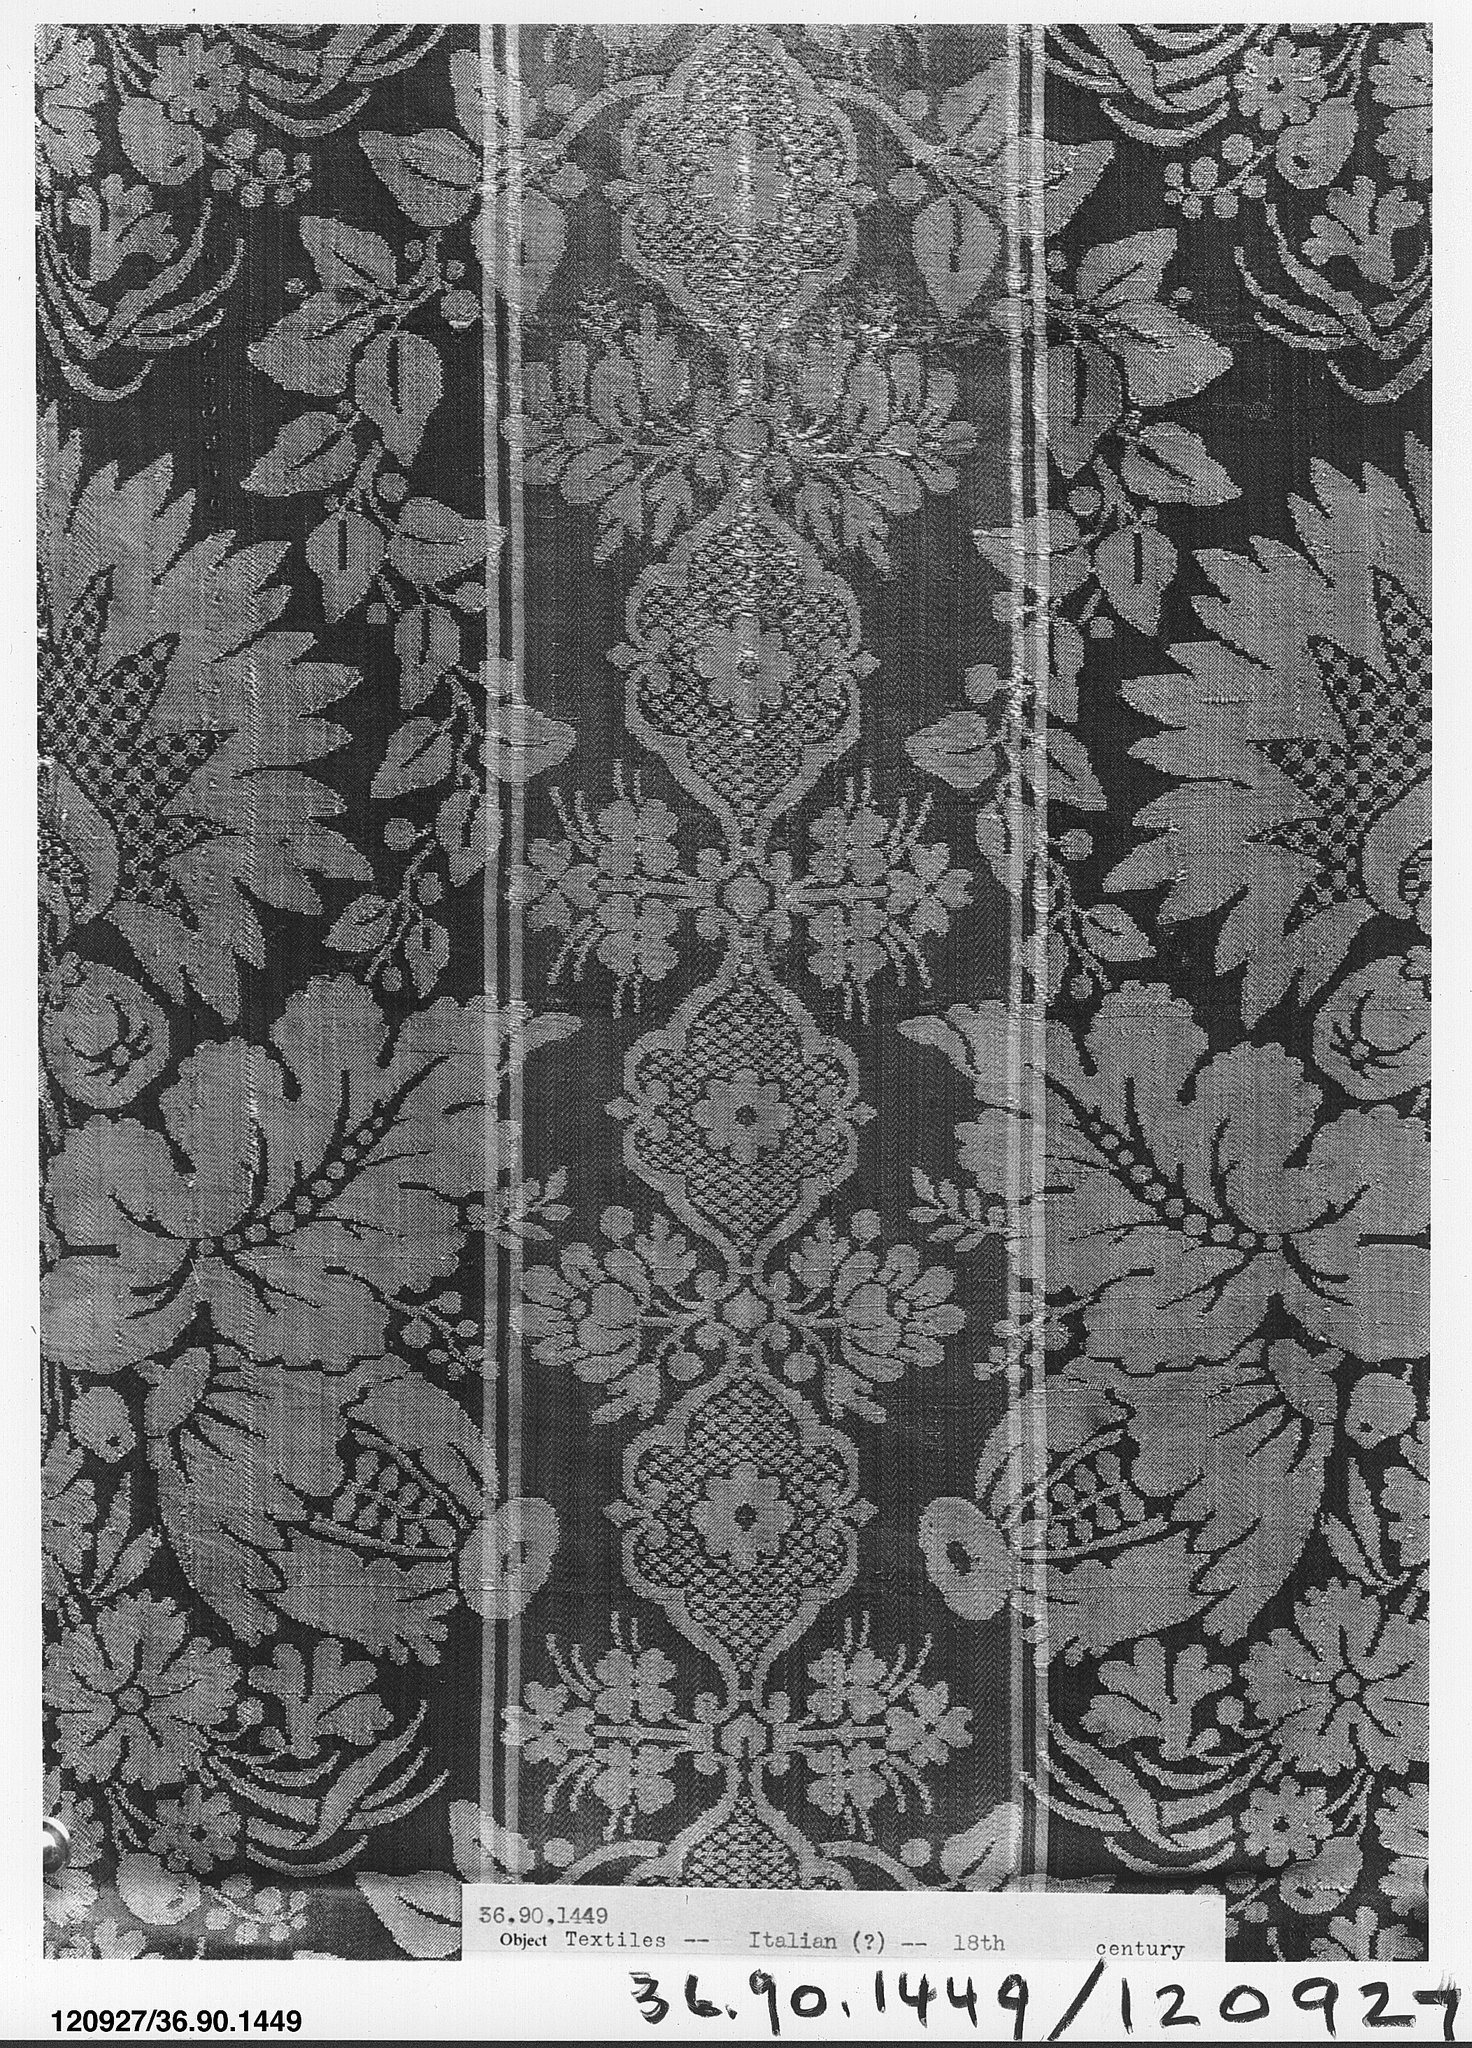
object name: piece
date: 1700-1710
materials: silk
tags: flowers,leaves